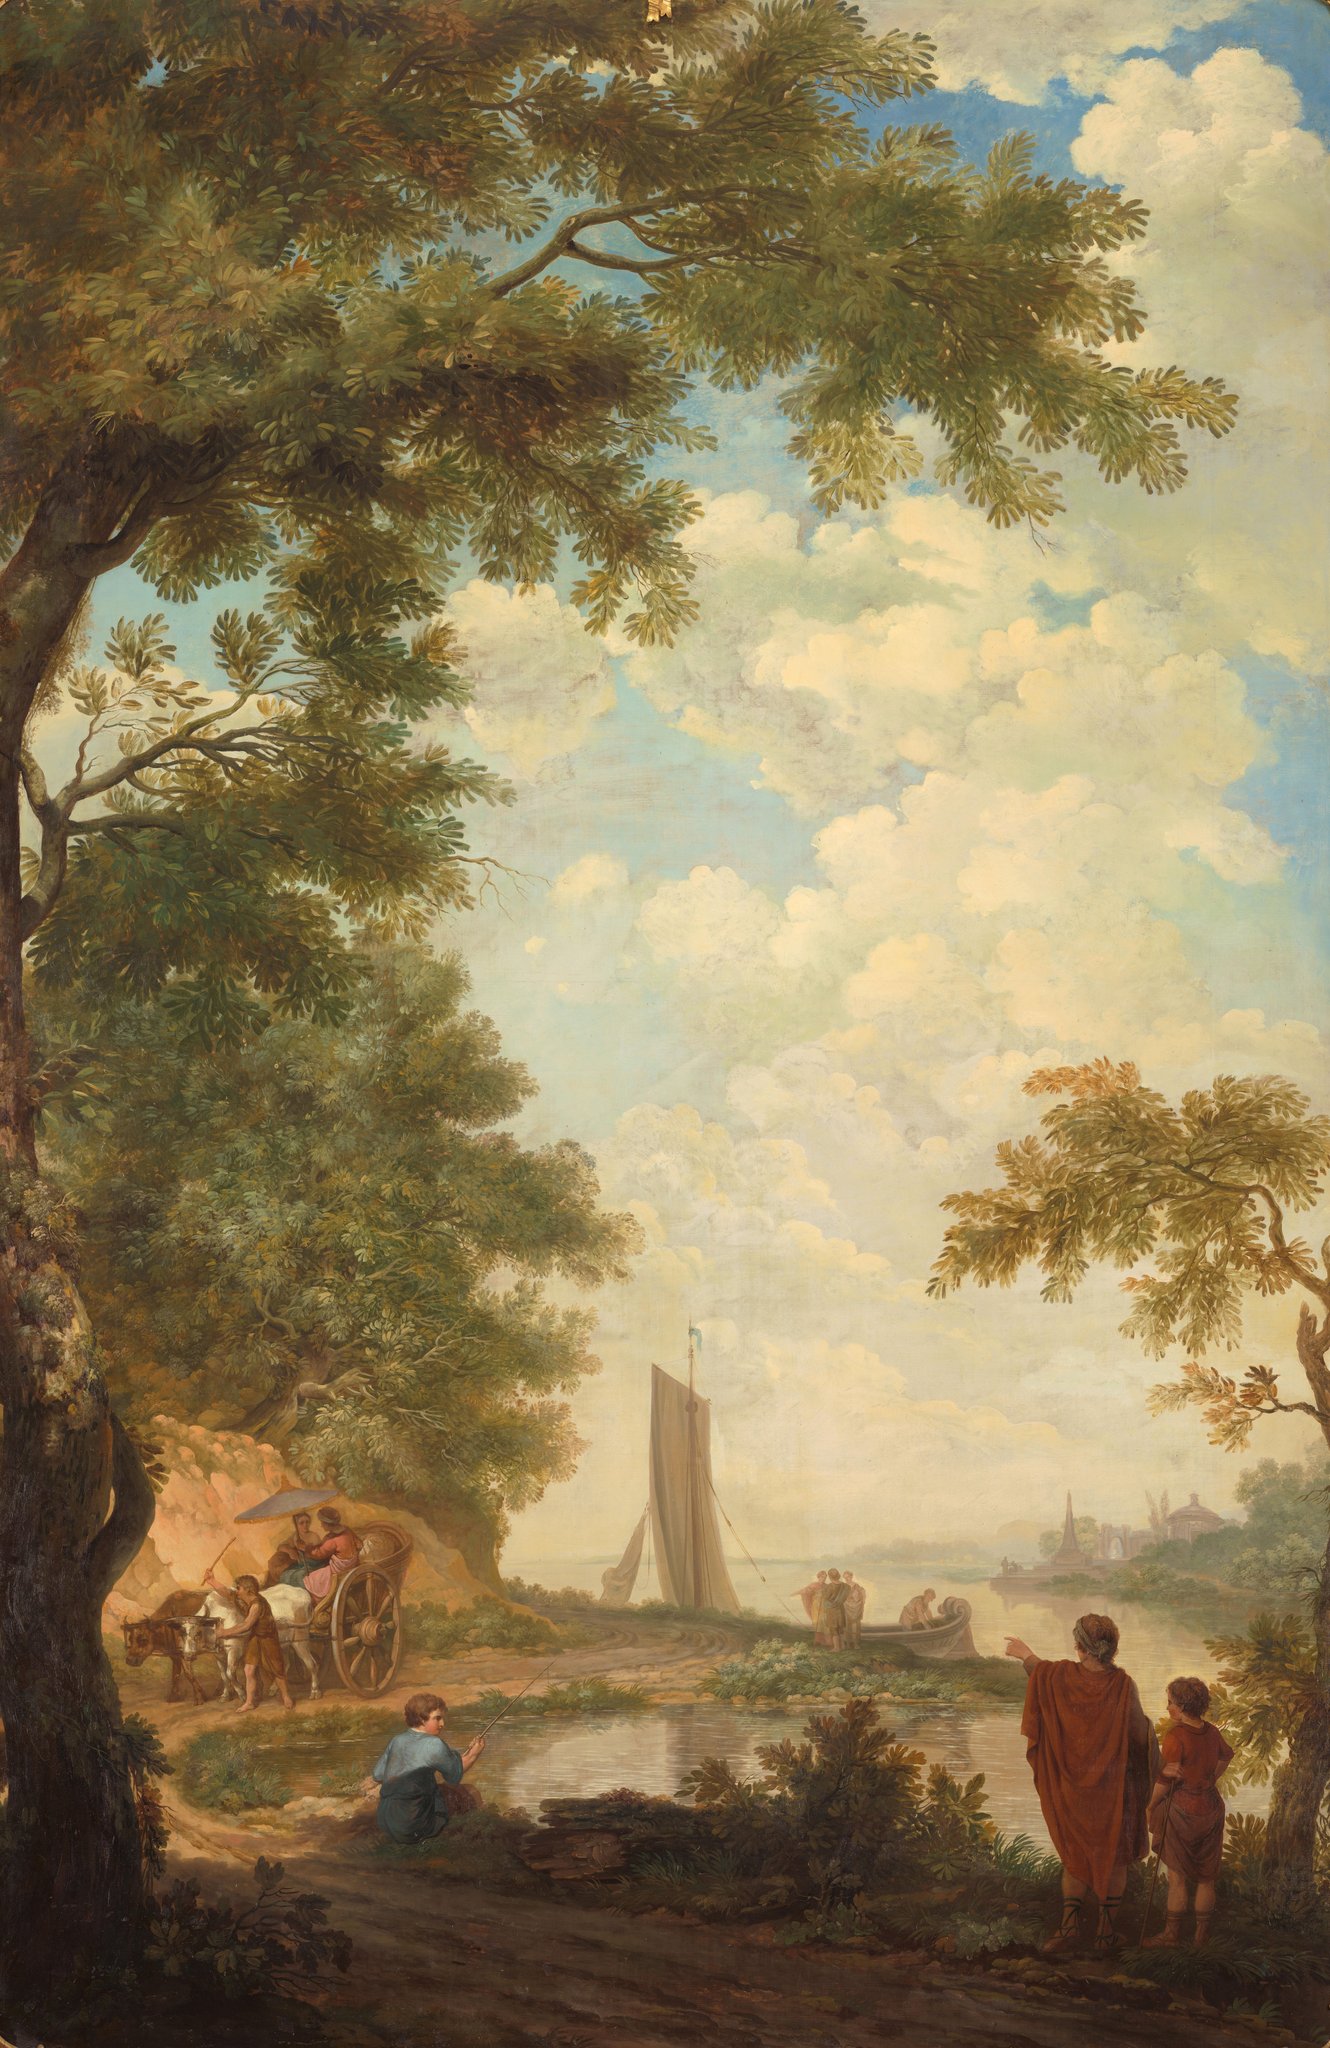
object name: mural painting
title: Arcadisch landschap met figuren bij een rivieroever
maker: jurriaan andriessen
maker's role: draughtsman, painter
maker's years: 1742-1819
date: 1771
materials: canvas, oil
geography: amsterdam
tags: pastorals, arcadian scenes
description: Wandschildering in het midden. Uit een serie van tien wandschilderingen met arcadische landschappen in de kamer aan de tuinkant op de hoofdverdieping van het huis Herengracht 524 te Amsterdam.